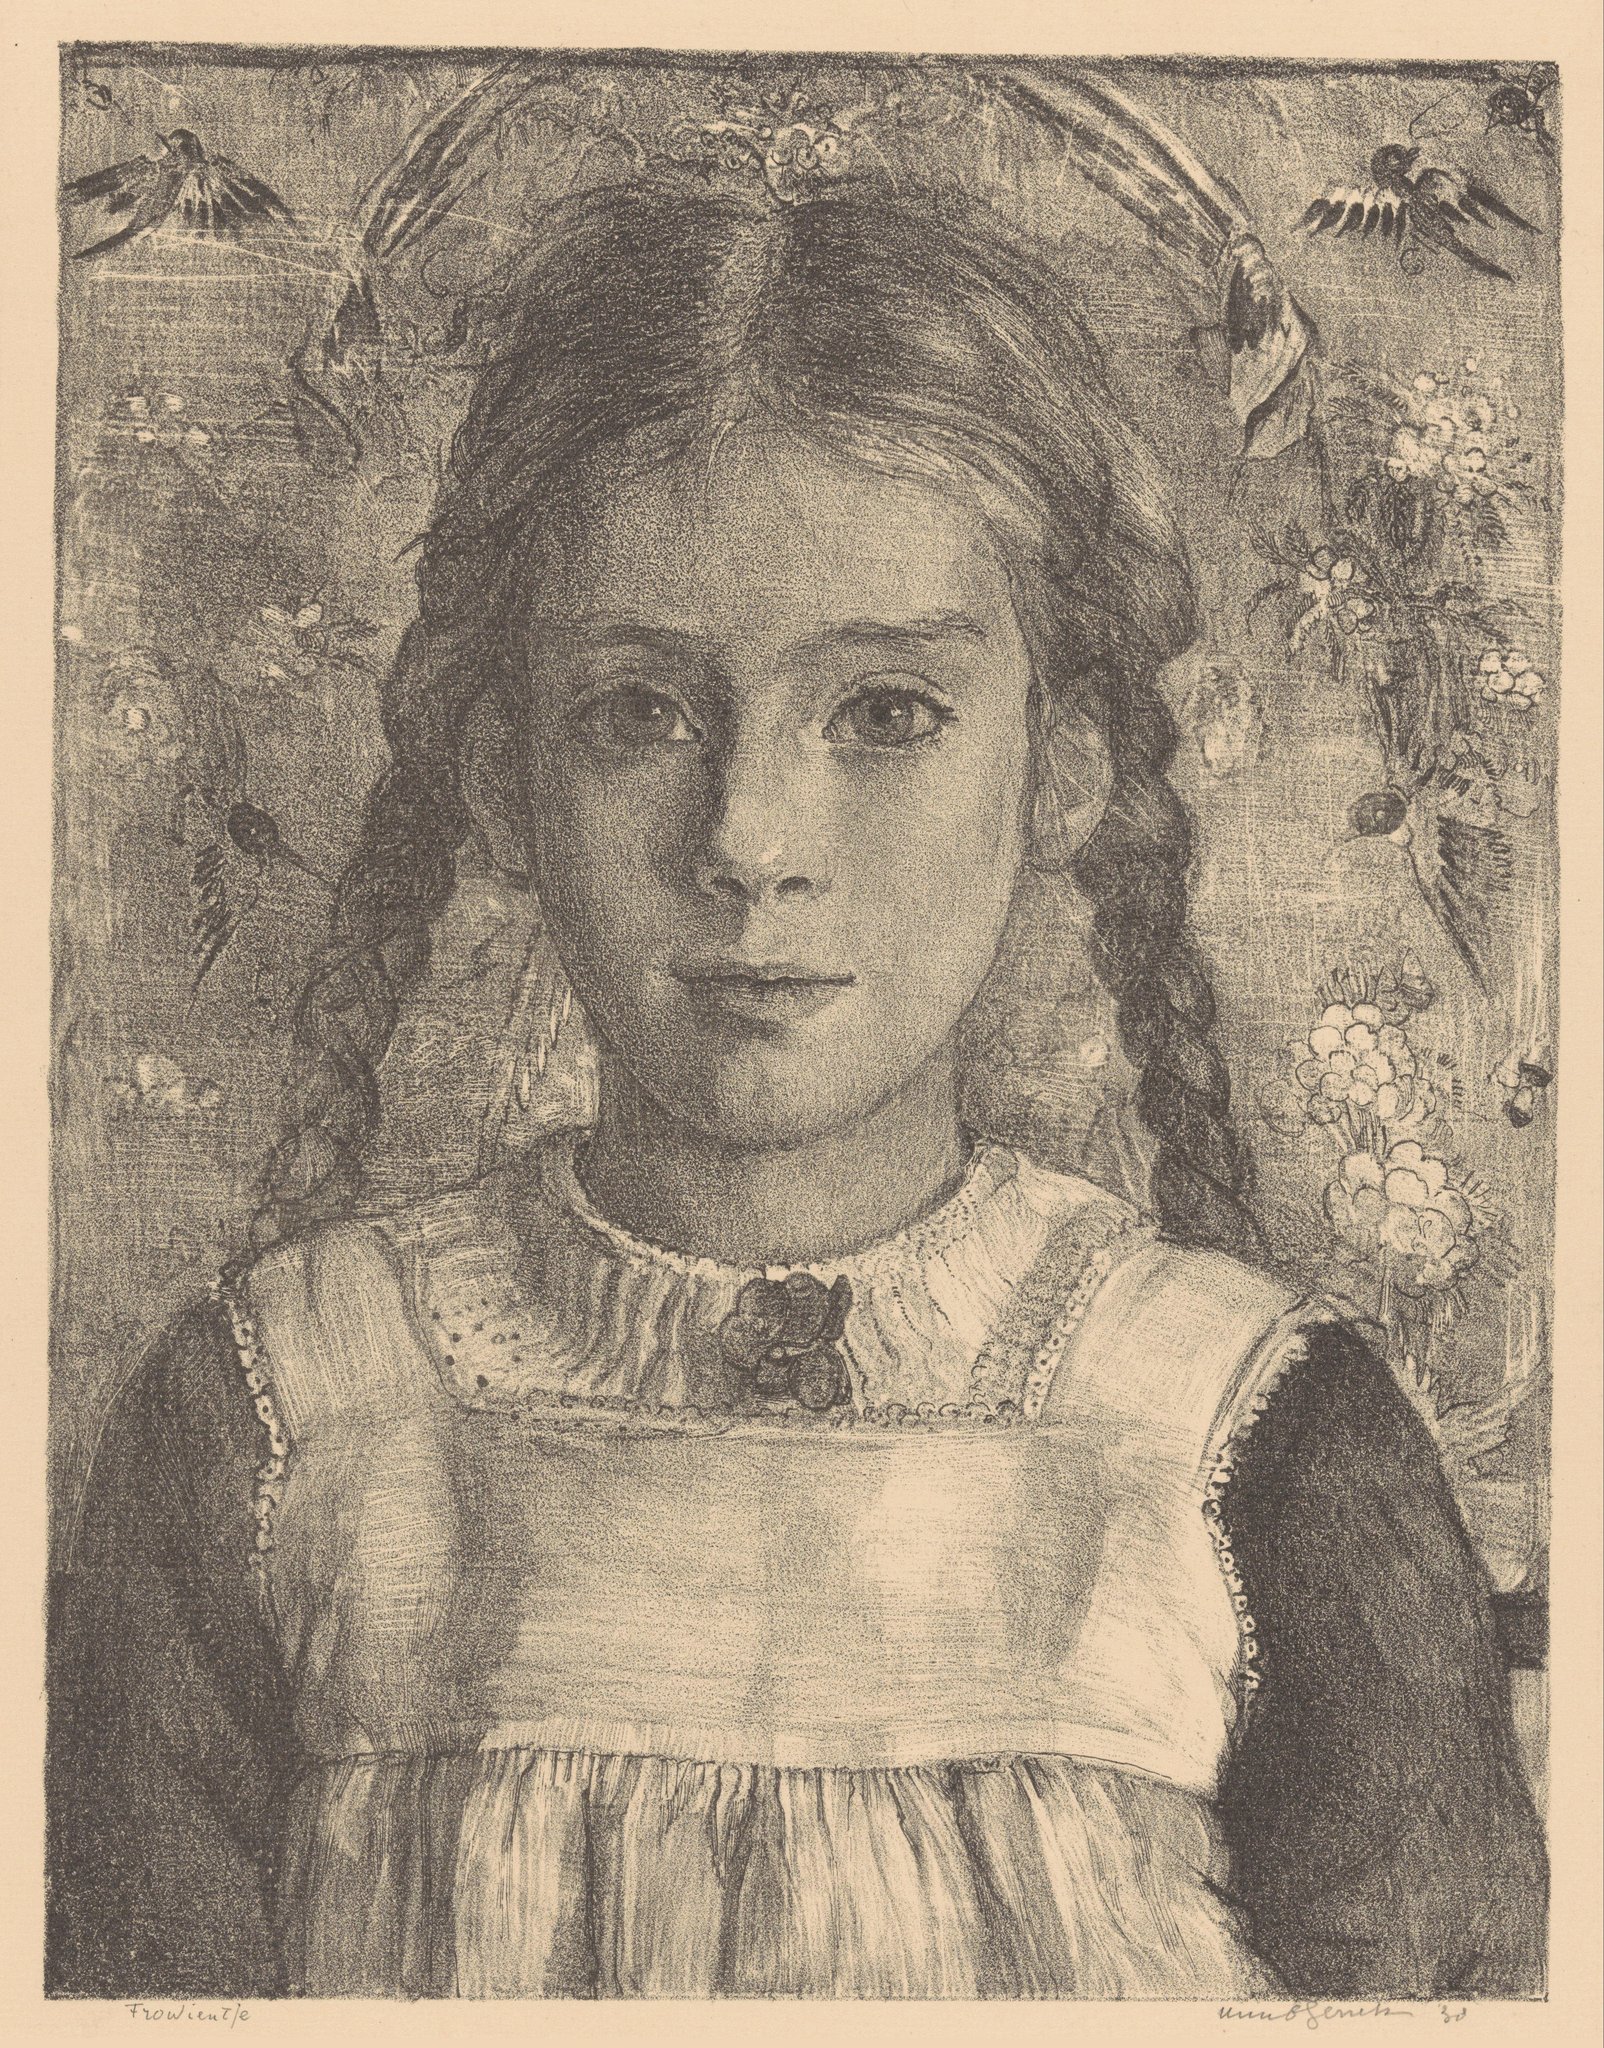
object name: print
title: Frowientje van Toorenburg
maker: huub gerretsen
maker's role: print maker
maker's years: 1897-1978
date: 1938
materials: paper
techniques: lithograph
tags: historical persons - bb - woman, child (at home) - aa - girl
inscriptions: collector's mark: Lugt 2228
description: Portret van een meisje met vlechten dat gekleed is in een jurk. Achter haar wandbehang met vogels en bloemen.